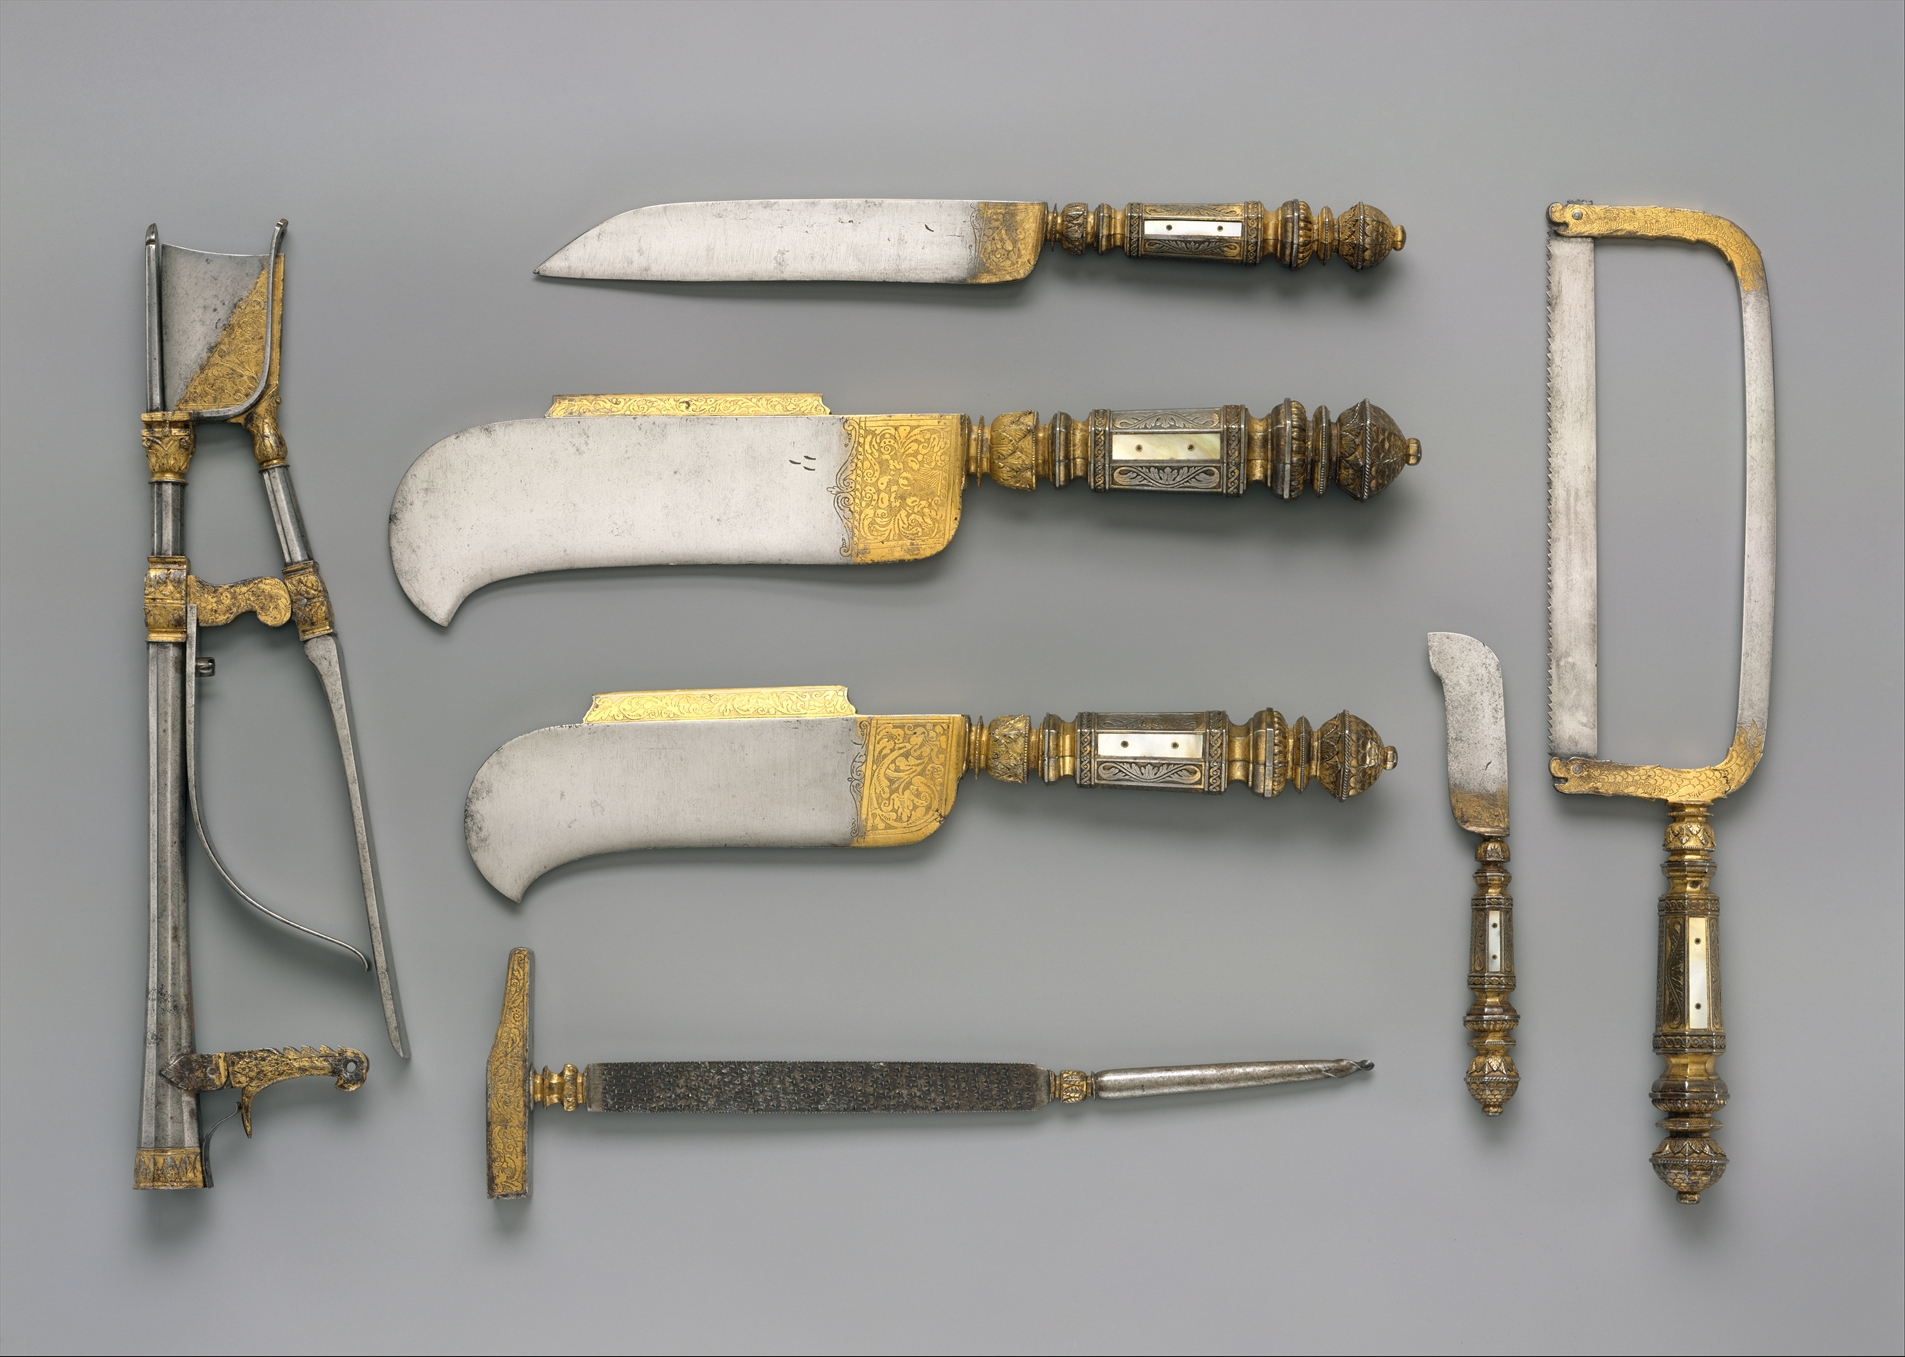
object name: pruning tool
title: Set of seven pruning tools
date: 1575-1600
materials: mother of pearl, steel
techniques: gilding